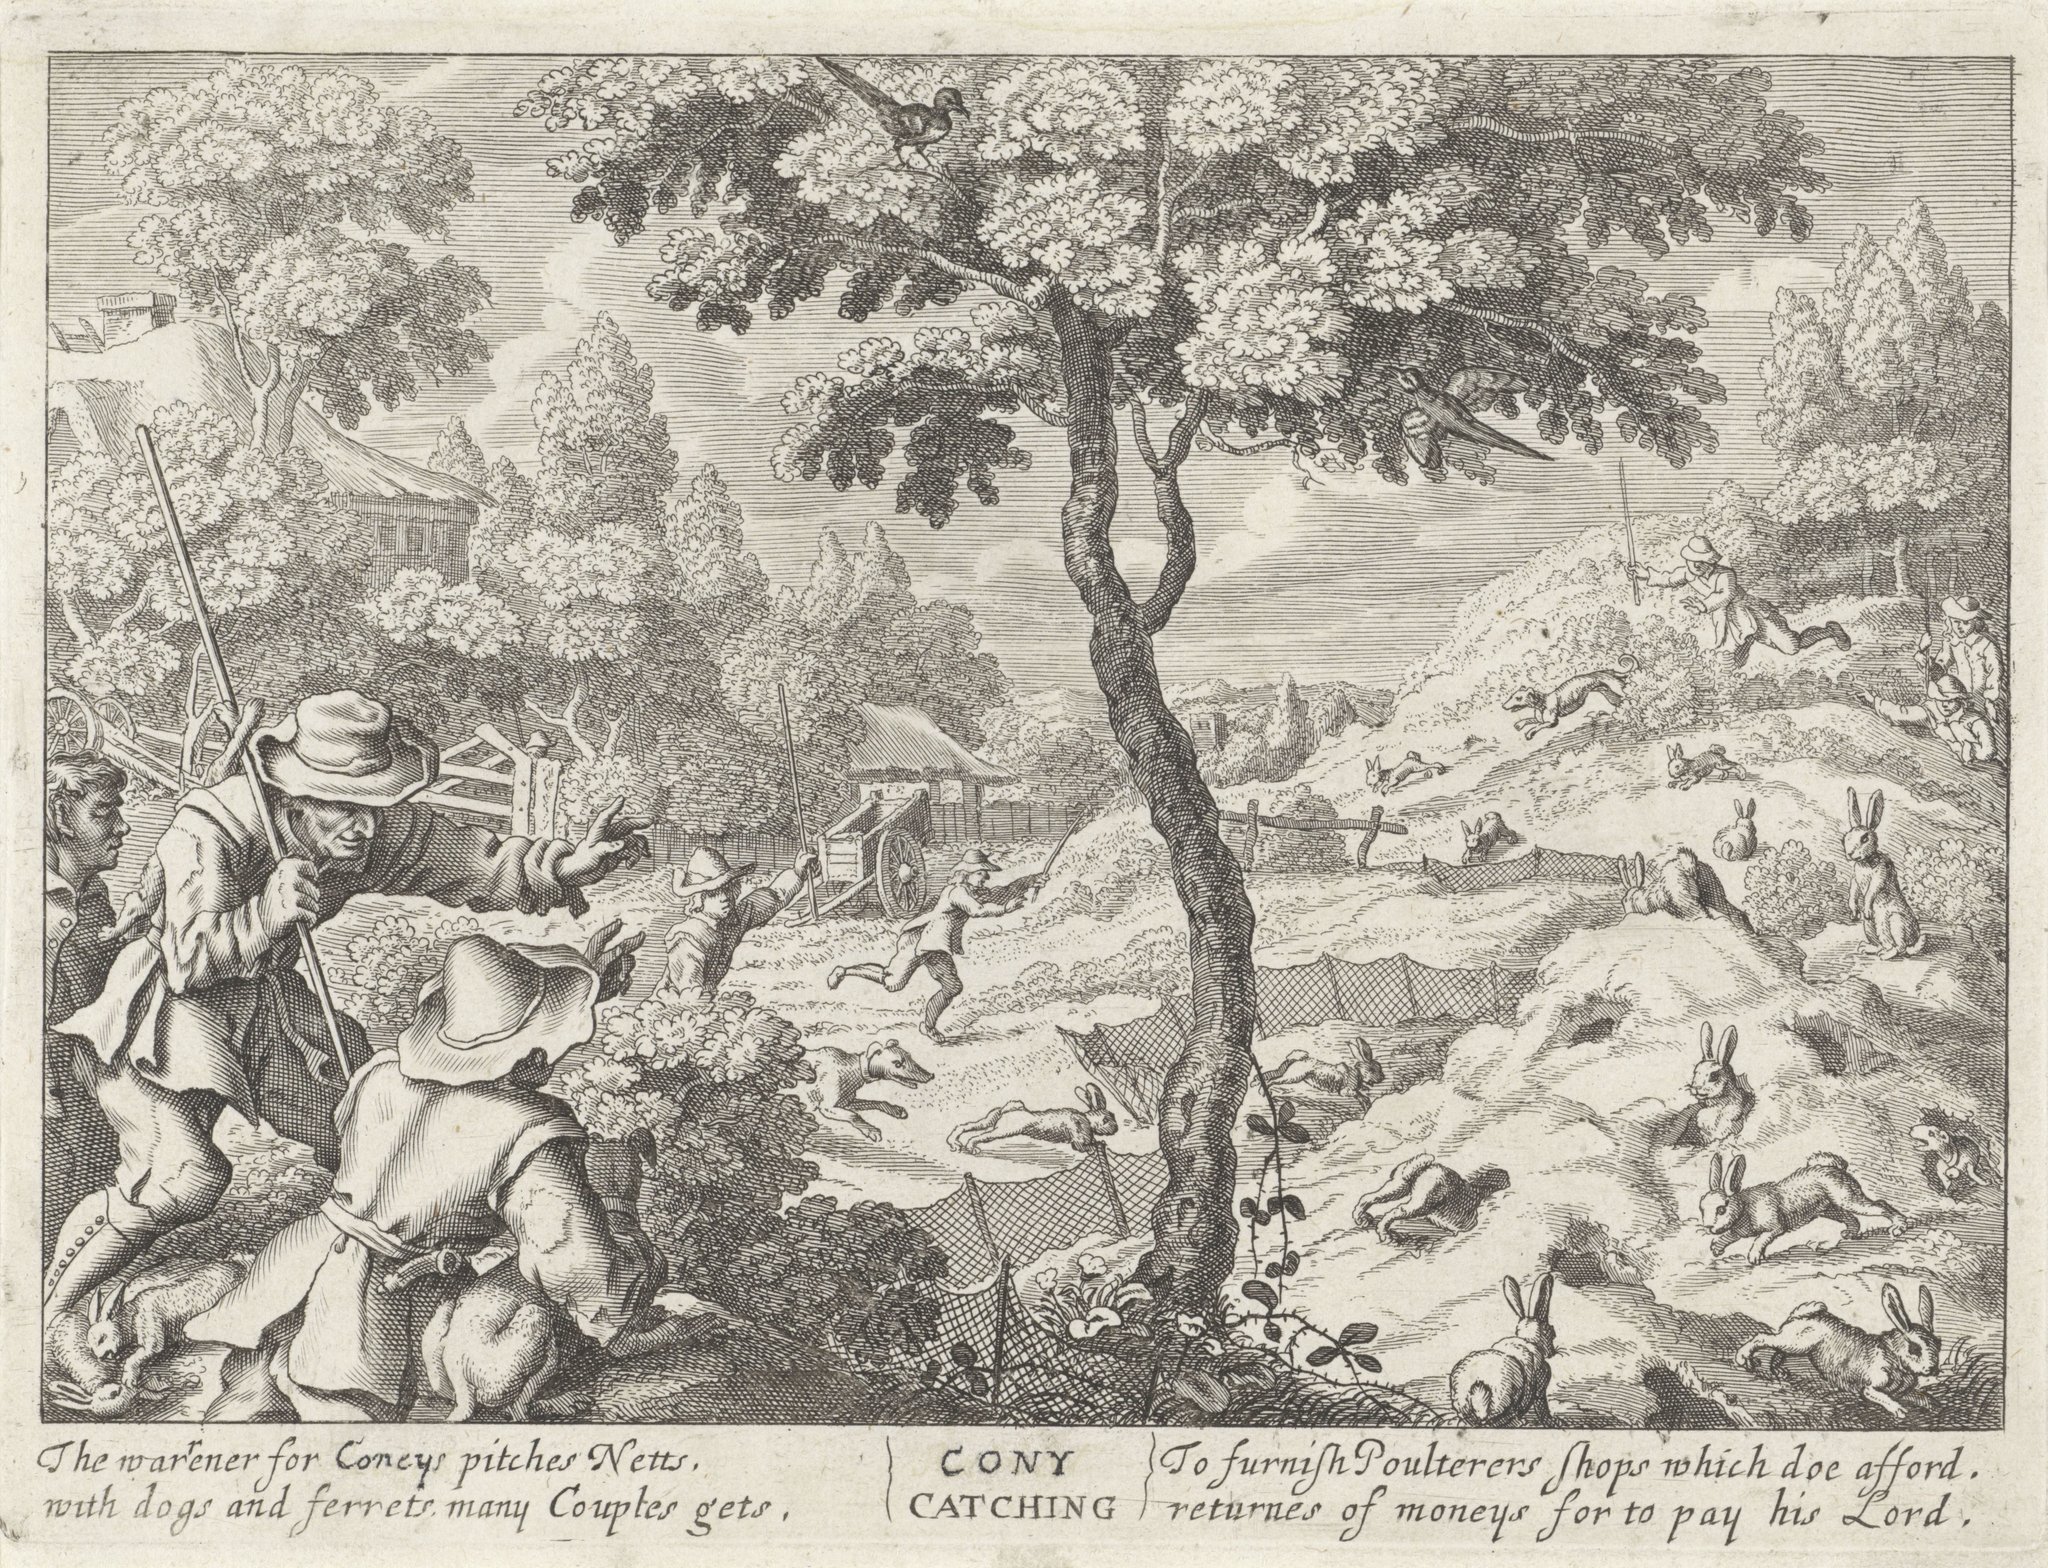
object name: print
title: Coney catching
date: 1671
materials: paper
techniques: etching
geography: london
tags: hunting dogs, hare-hunting, rabbit-hunting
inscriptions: collector's mark: Lugt 2760, collector's mark: Lugt 2228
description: De prent maakt deel uit van de twaalfdelige serie: Severall Wayes of Hunting, Hawking, and Fishing, According to the English Manner, 1671. Vier van de twaalf prenten uit deze serie zijn van Hollar's hand. De resterende acht prenten zijn ongesigneerd en waarschijnlijk door Richard Gaywood (zie NHG(2009)).